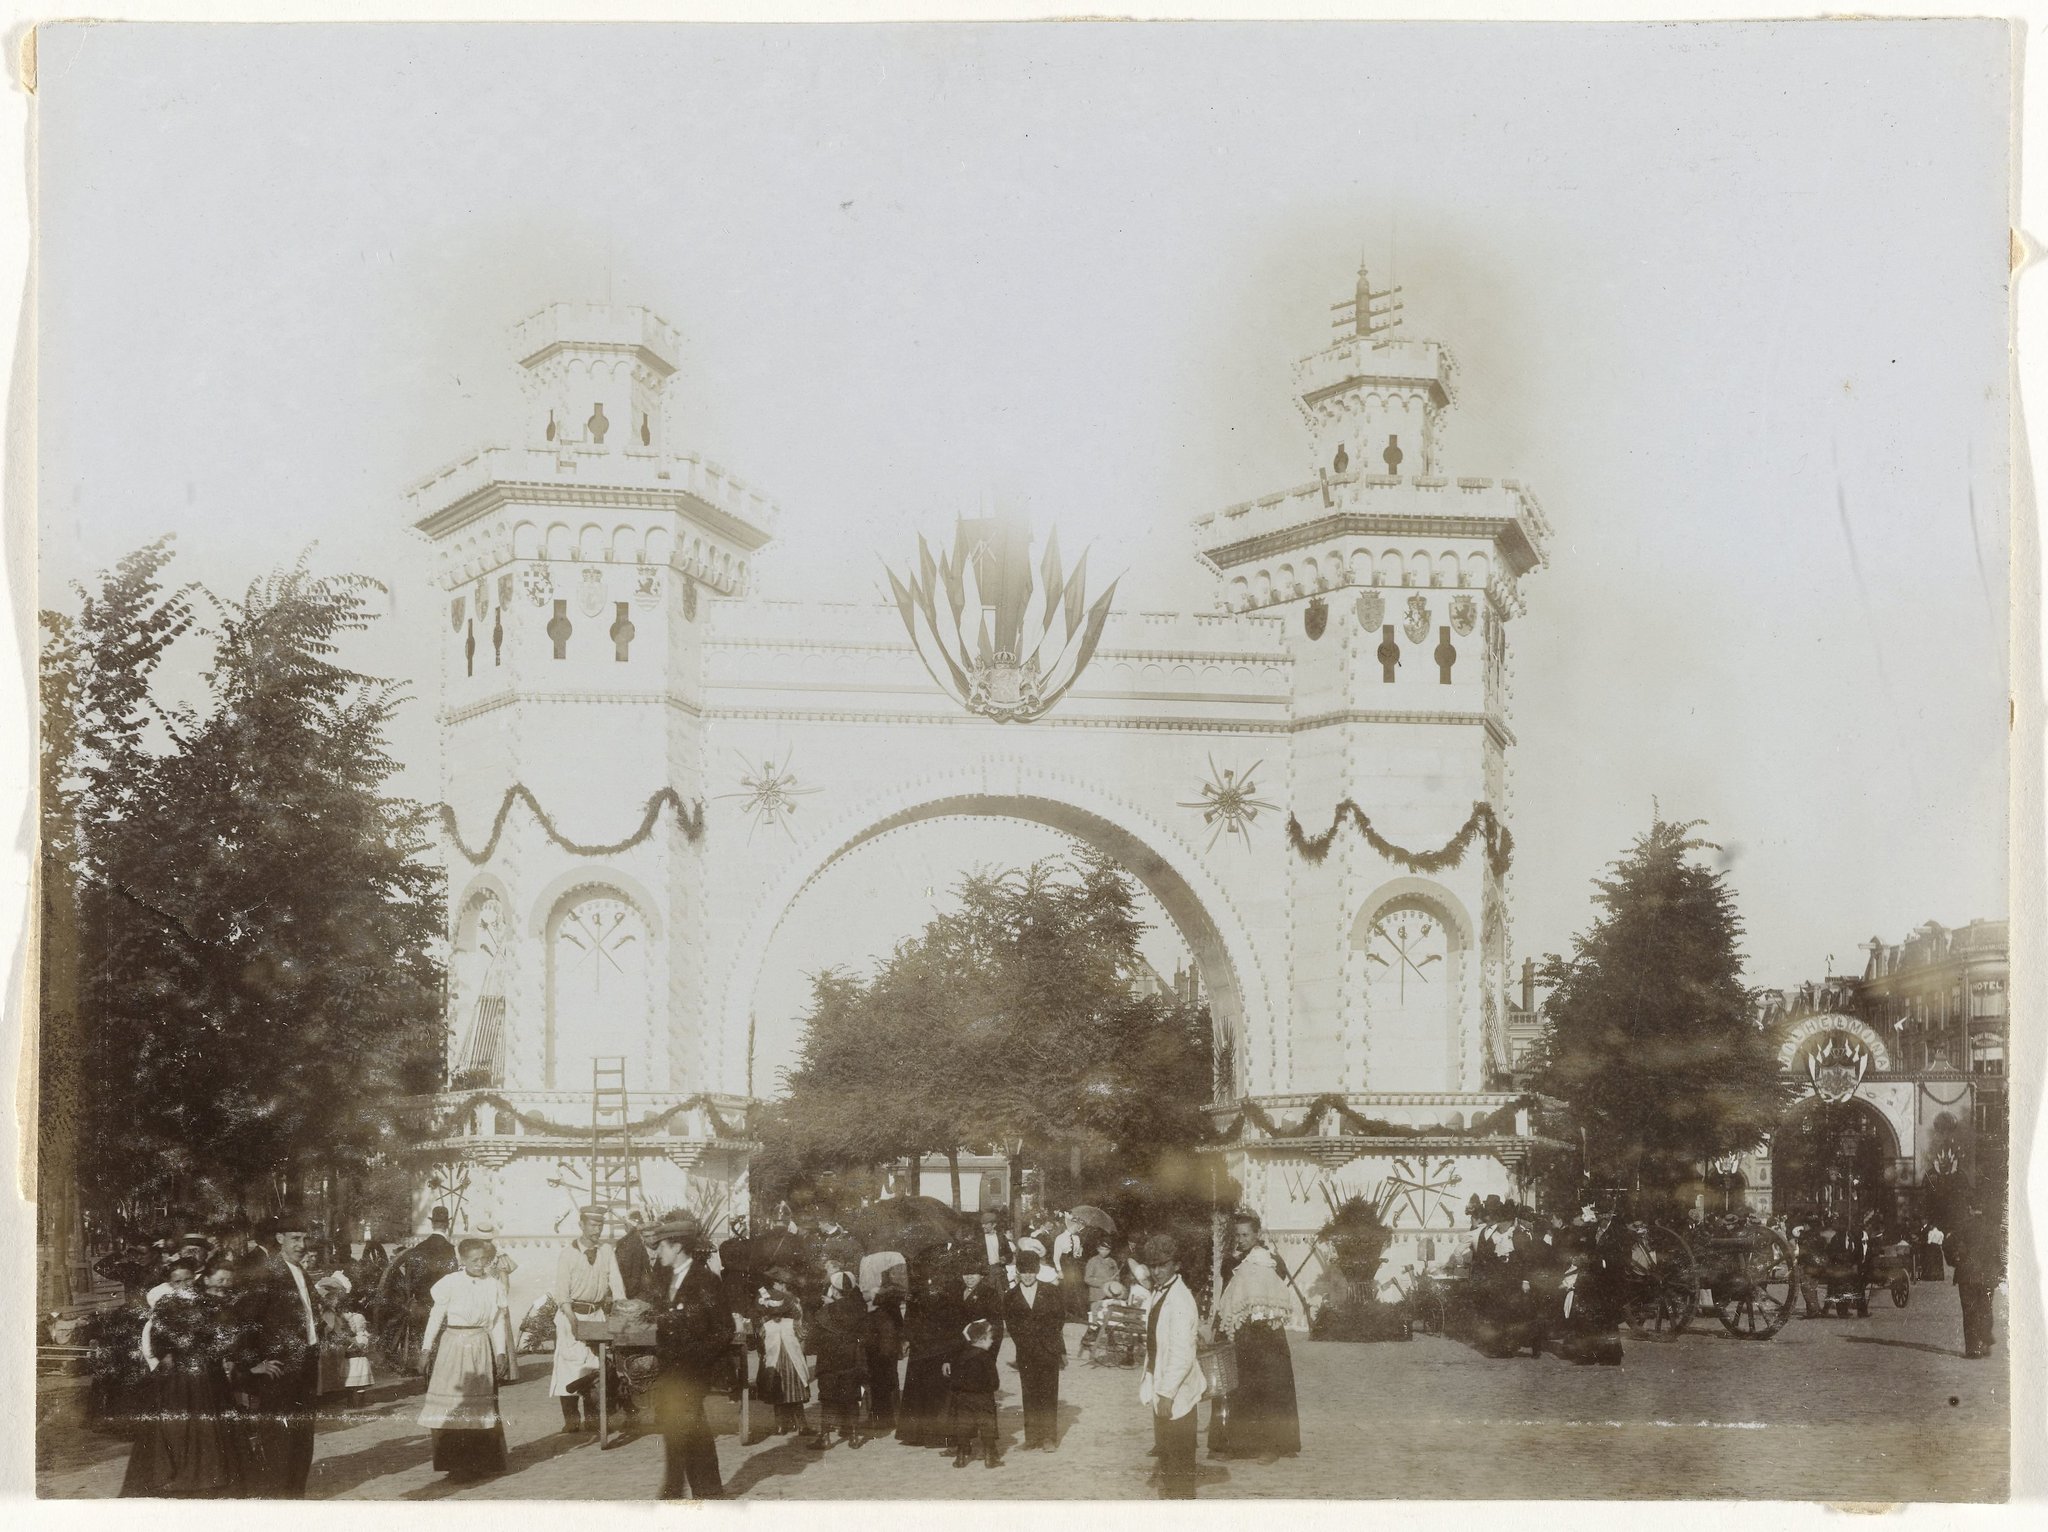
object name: photograph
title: Erepoort op de Mauritskade ter gelegenheid van de inhuldiging van koningin Wilhelmina, gezien vanaf de Von Zesenstraat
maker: Anonymous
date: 1809-1898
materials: paper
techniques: collodion silver print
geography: mauritskade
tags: public festivities, city-gate